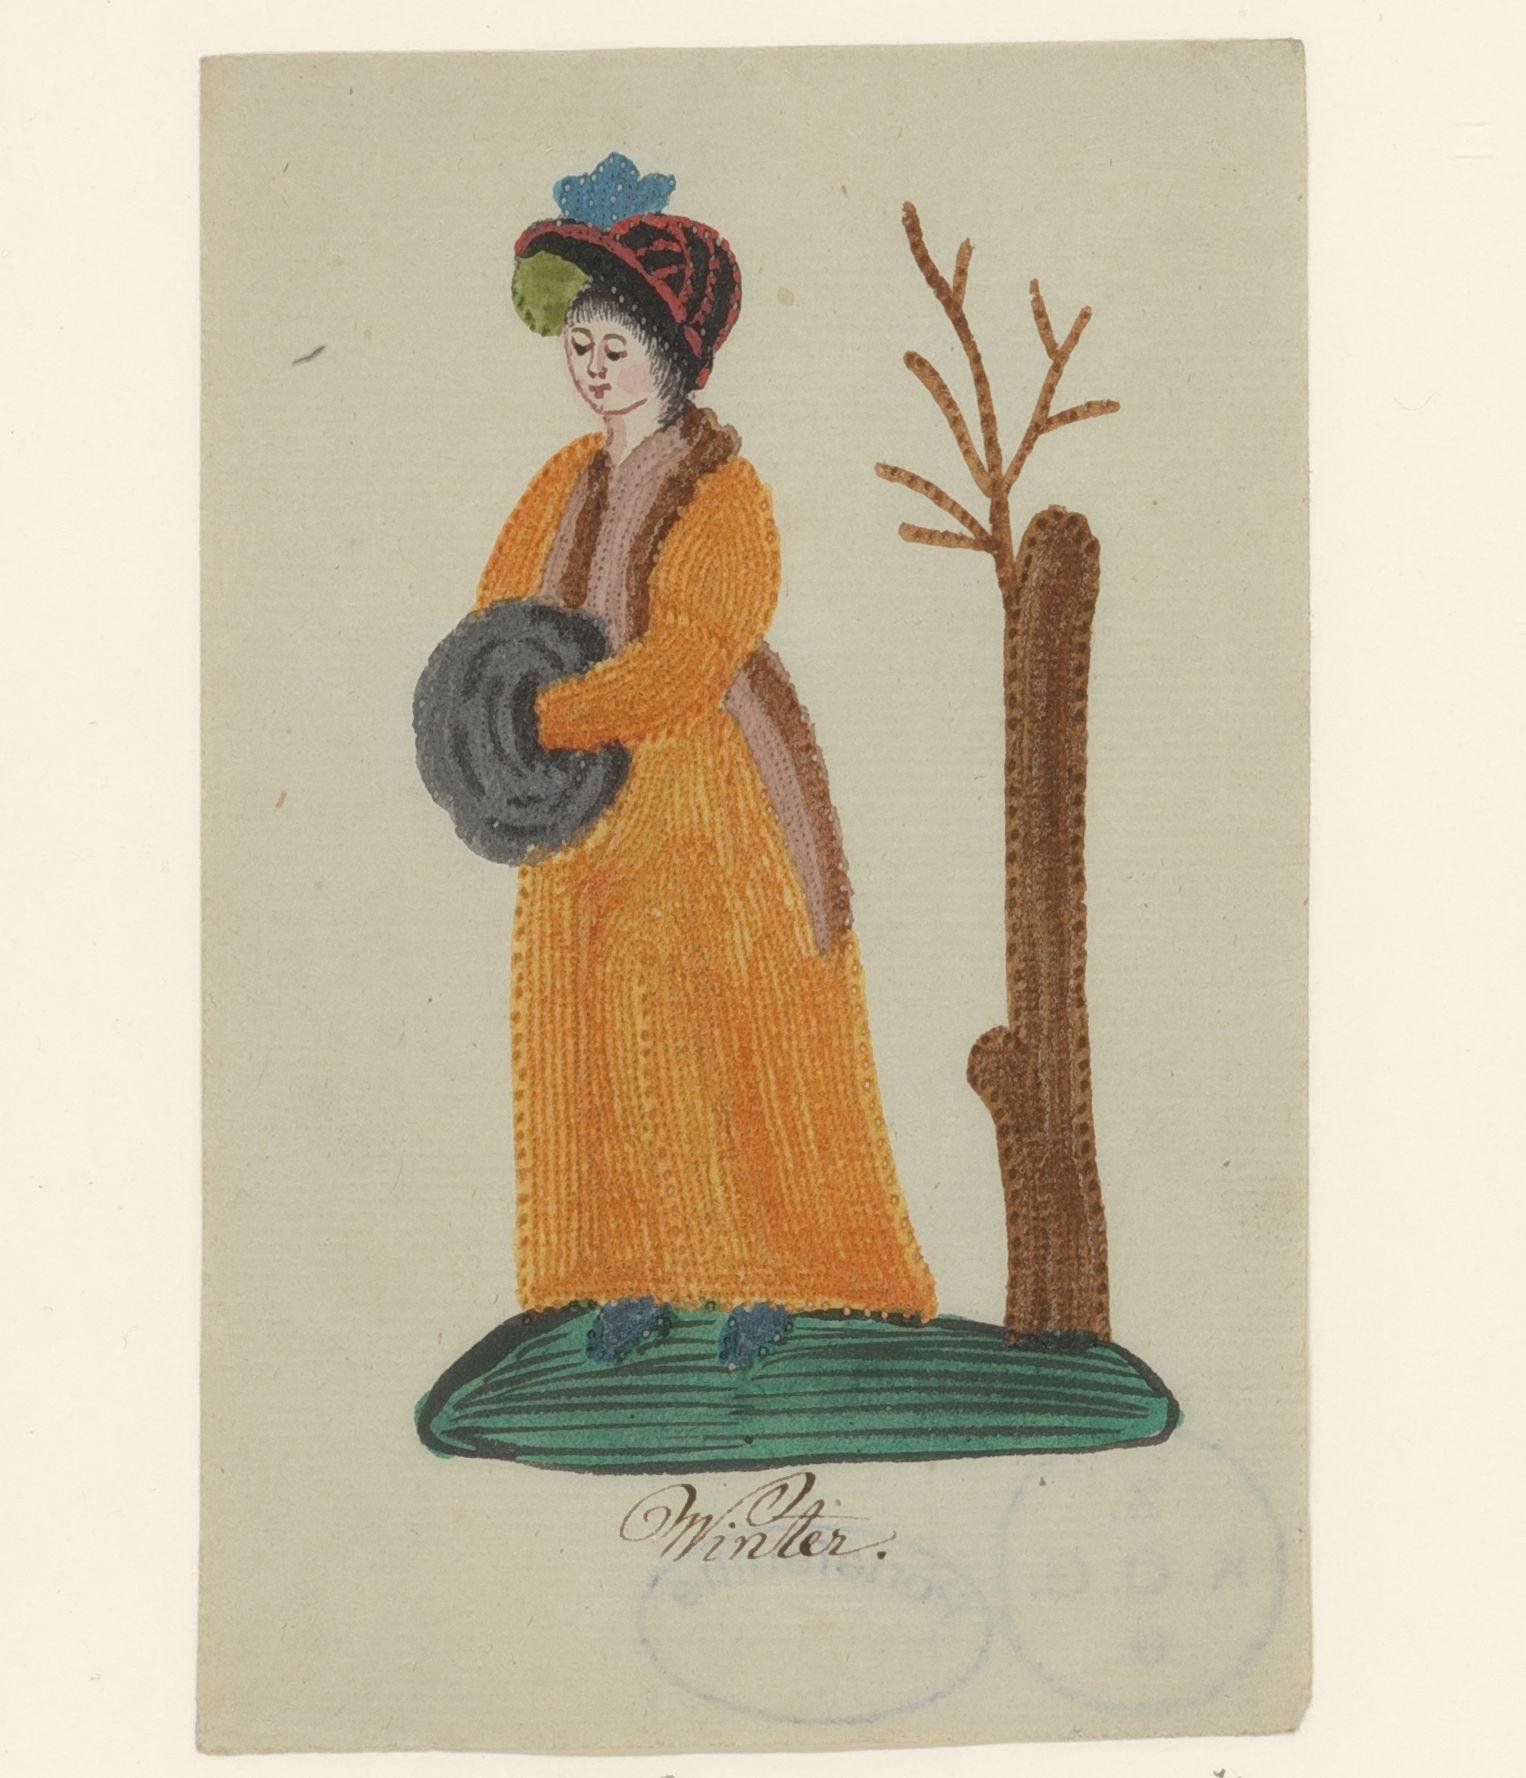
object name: drawing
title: Vrouw met mof bij een kale boom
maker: Anonymous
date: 1800-1899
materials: gouache, paper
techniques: brush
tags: trees, standing figure (canon, proportions) - aa - female human figure, muff, winter, 'hyems'; 'inverno' (ripa)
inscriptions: stamp, collector's mark: Lugt 1641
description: Onderwerpsrubrieken binnen de Atlas Zeden en Gewoonten: Schoone kunsten, Diverse liefhebberijen (o.a. prikprenten).